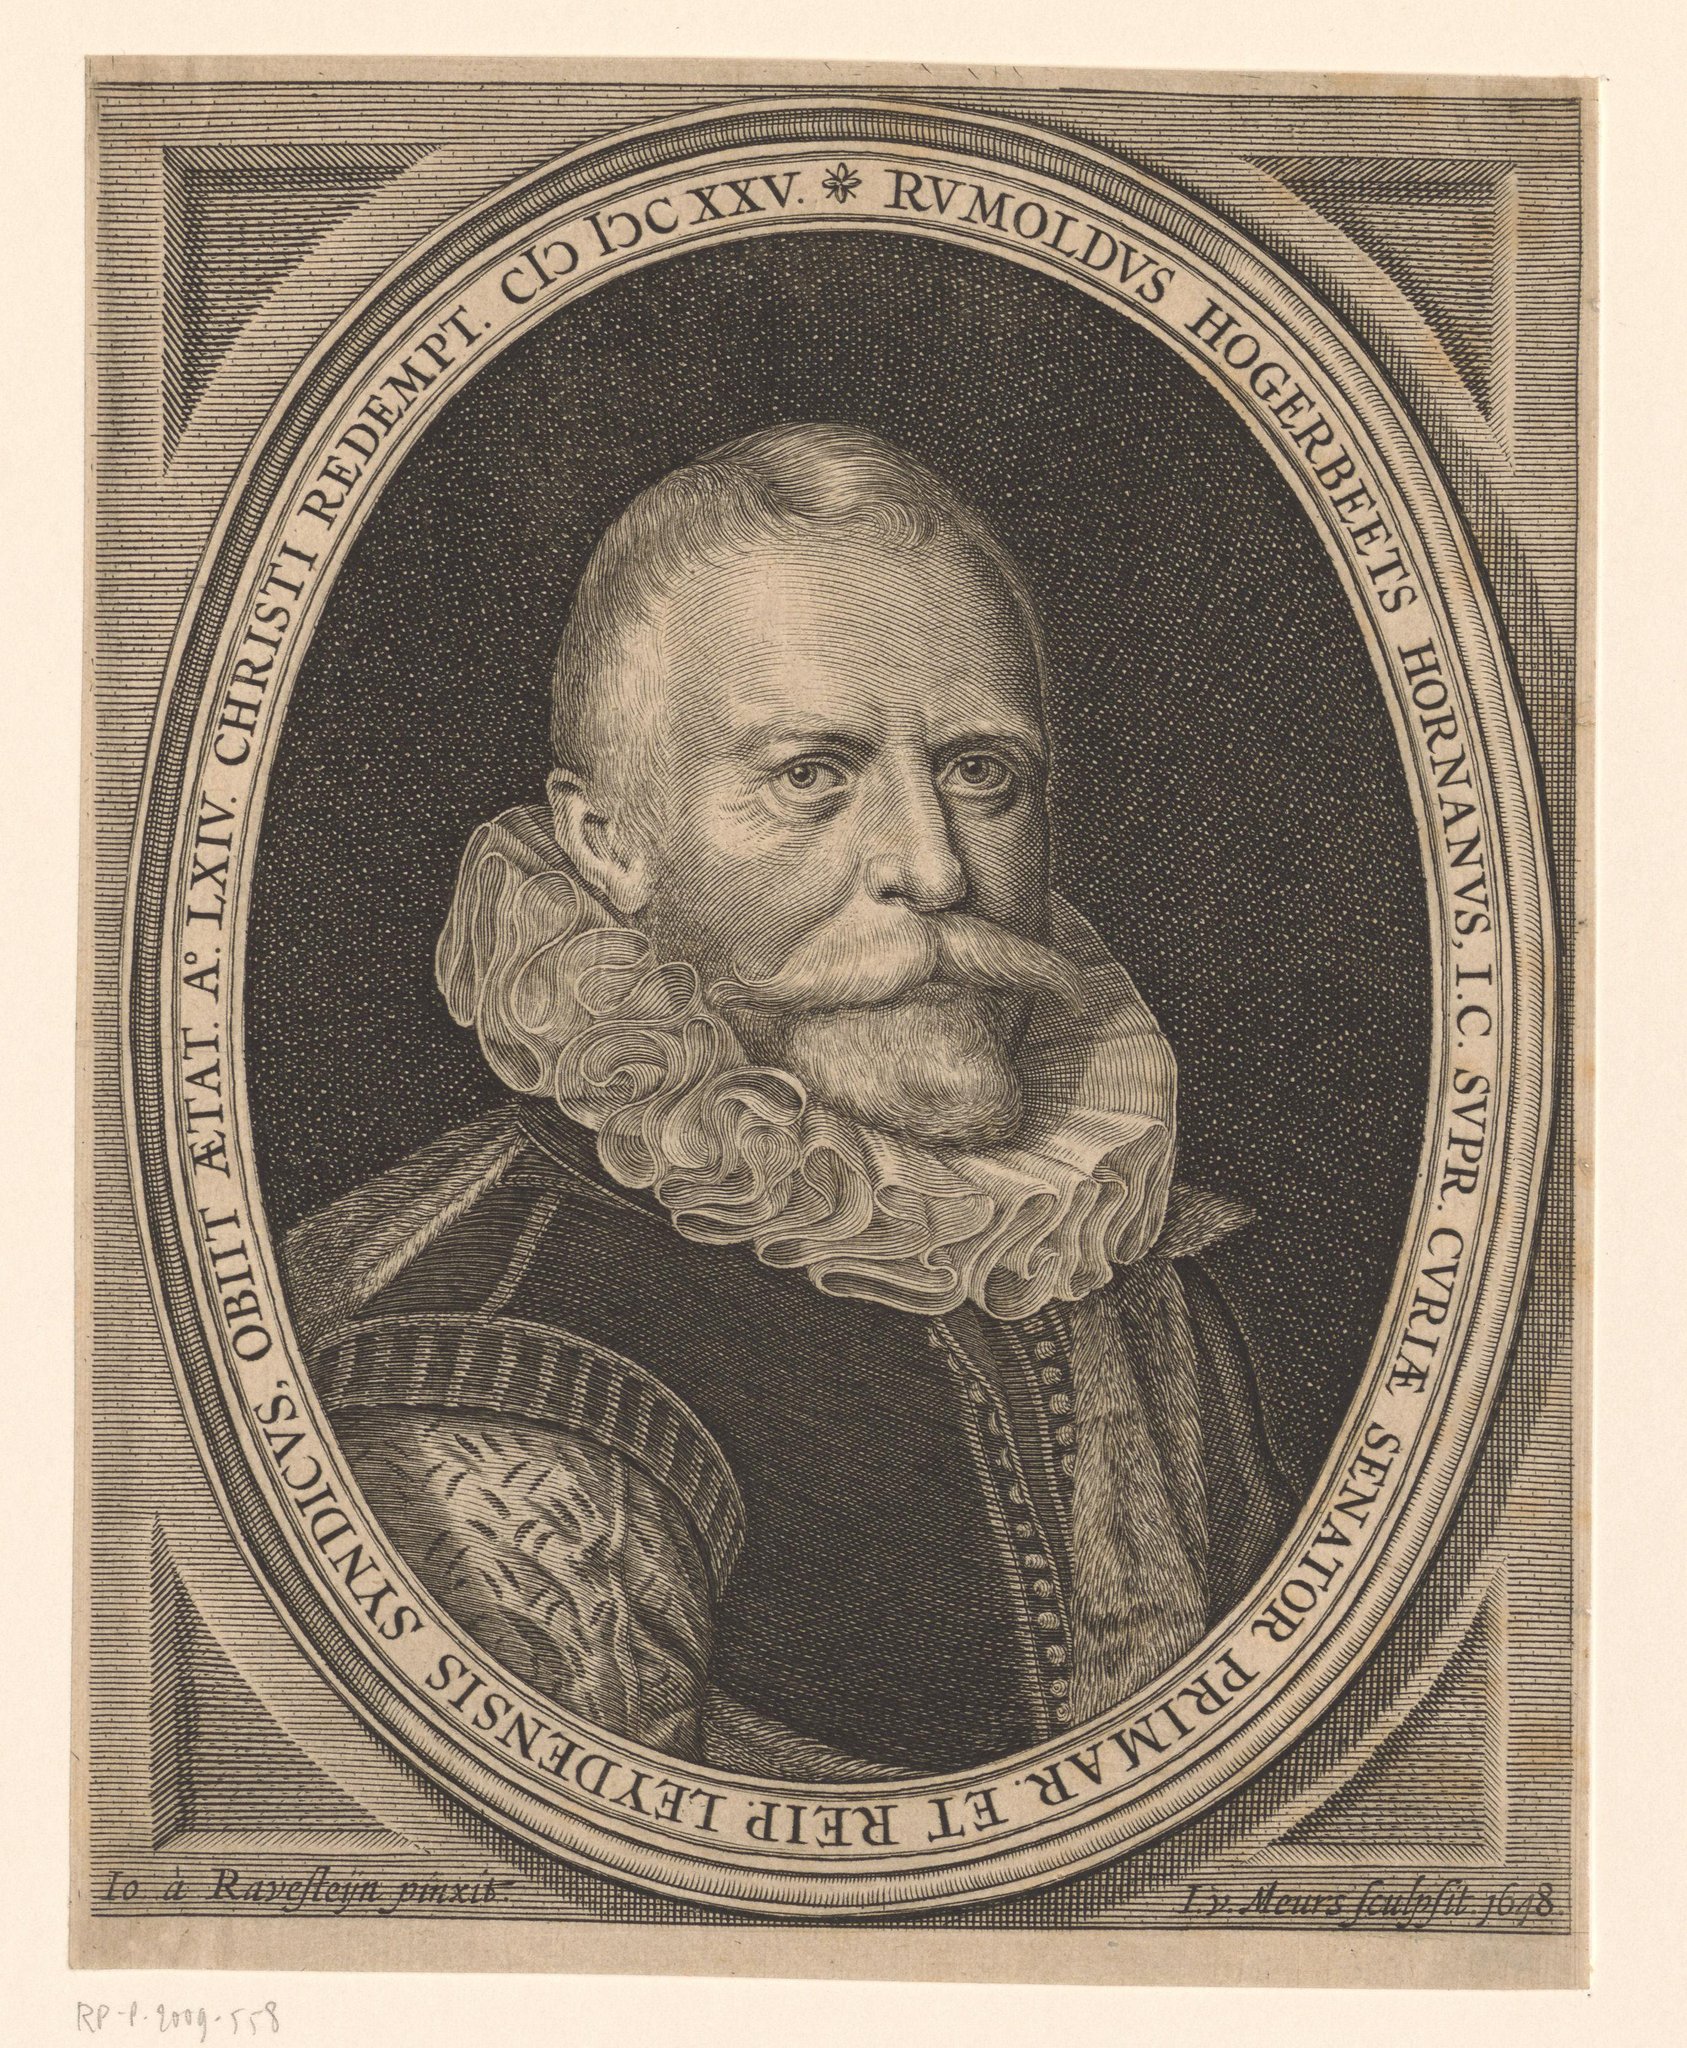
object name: print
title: Portret van Rombout Hogerbeets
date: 1648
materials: paper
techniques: engraving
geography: haarlem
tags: moustache, historical persons, neck-gear: collar (+ men's clothes), beard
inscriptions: collector's mark: Lugt 2228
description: Portret van Rumoldus Hogerbeets (1561-1625), pensionaris van Leiden. Geportretteerd op 64-jarige leeftijd. Portret in ovaal in kostuum met brede kraag naar rechts. In rand om ovaal Latijnse regels. Ovaal in omlijsting.